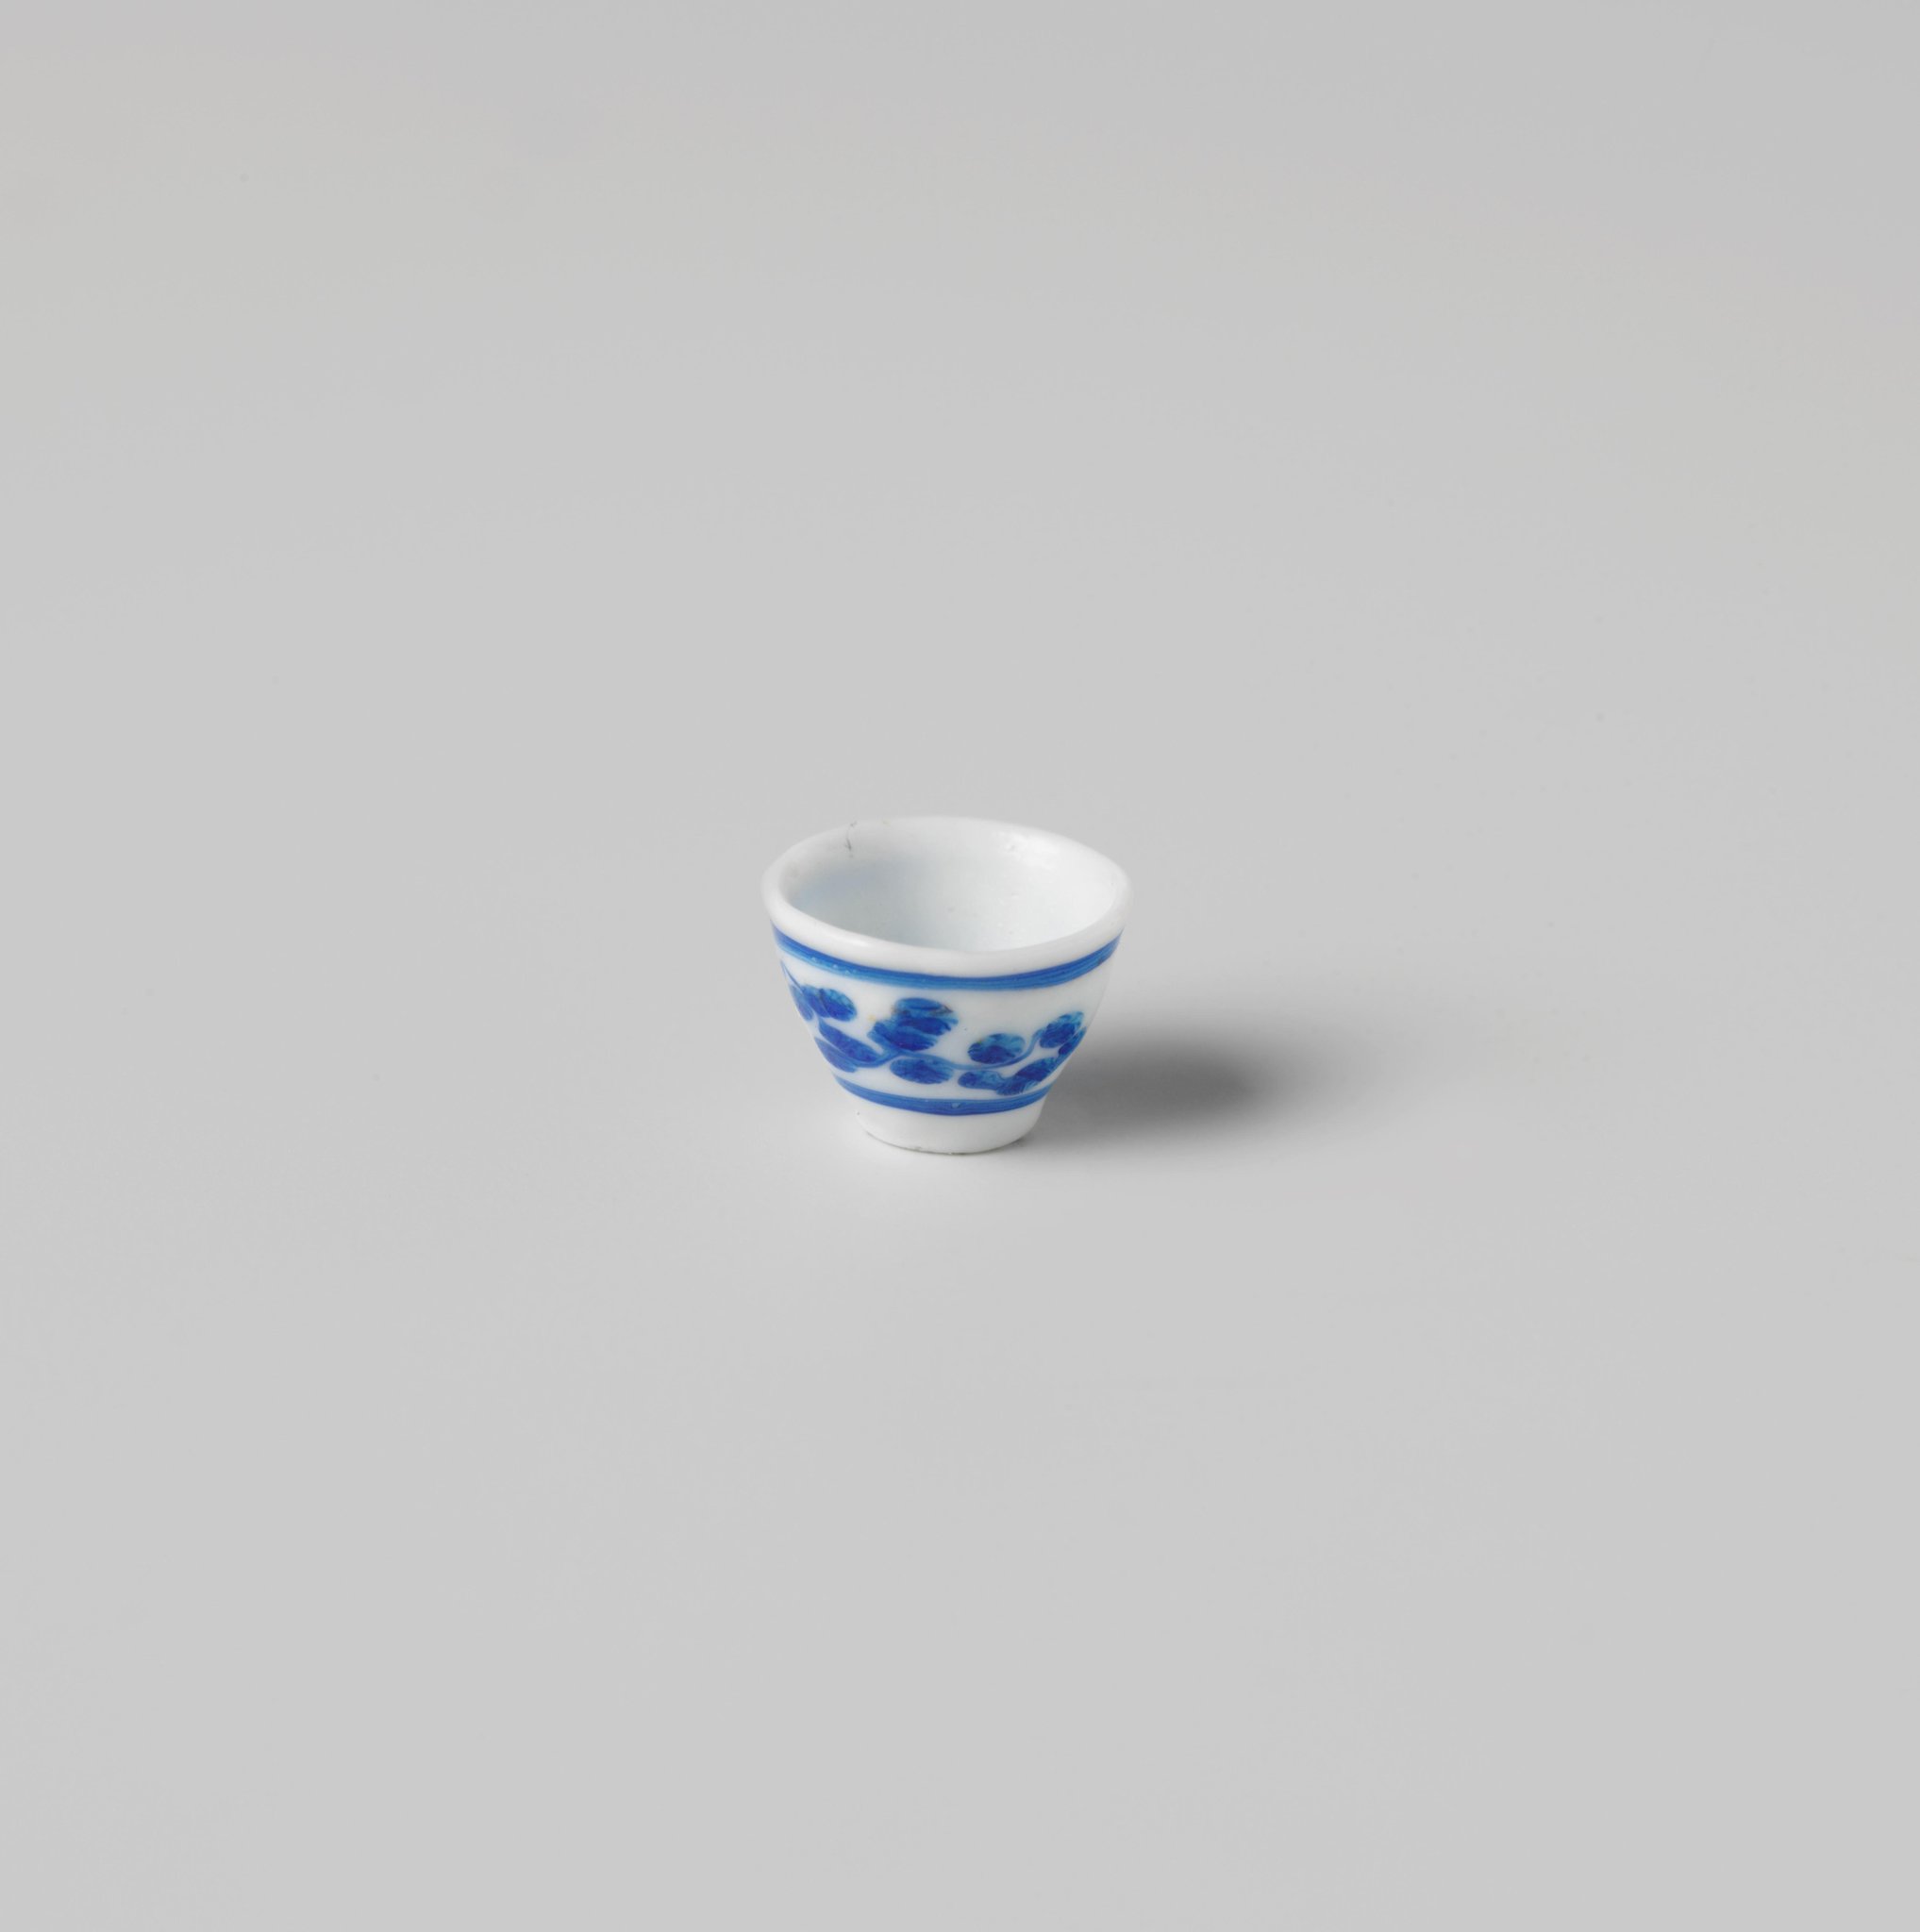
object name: miniature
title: Kom, wit, beschilderd in blauw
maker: Anonymous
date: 1675-1699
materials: glass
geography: haarlem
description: Kom van melkglas met blauwe emailverf beschilderd. Imitatie chinees blauw porselein.